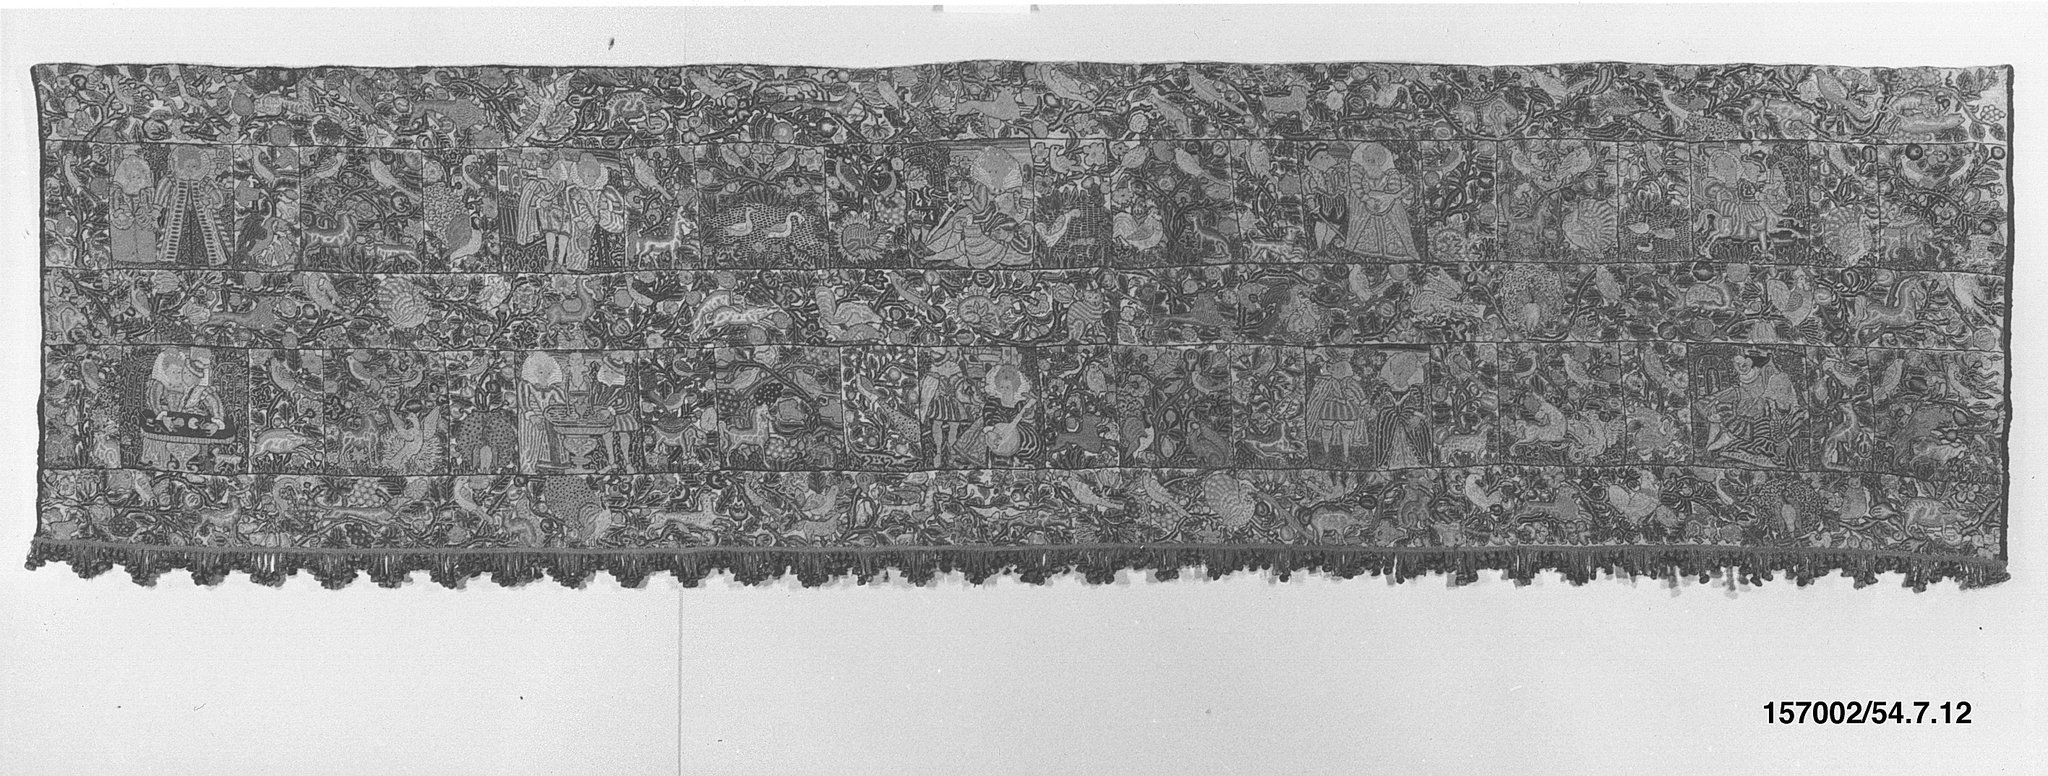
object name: panel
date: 1567-1633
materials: canvas, metal thread, silk, wool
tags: animals,birds,men,women